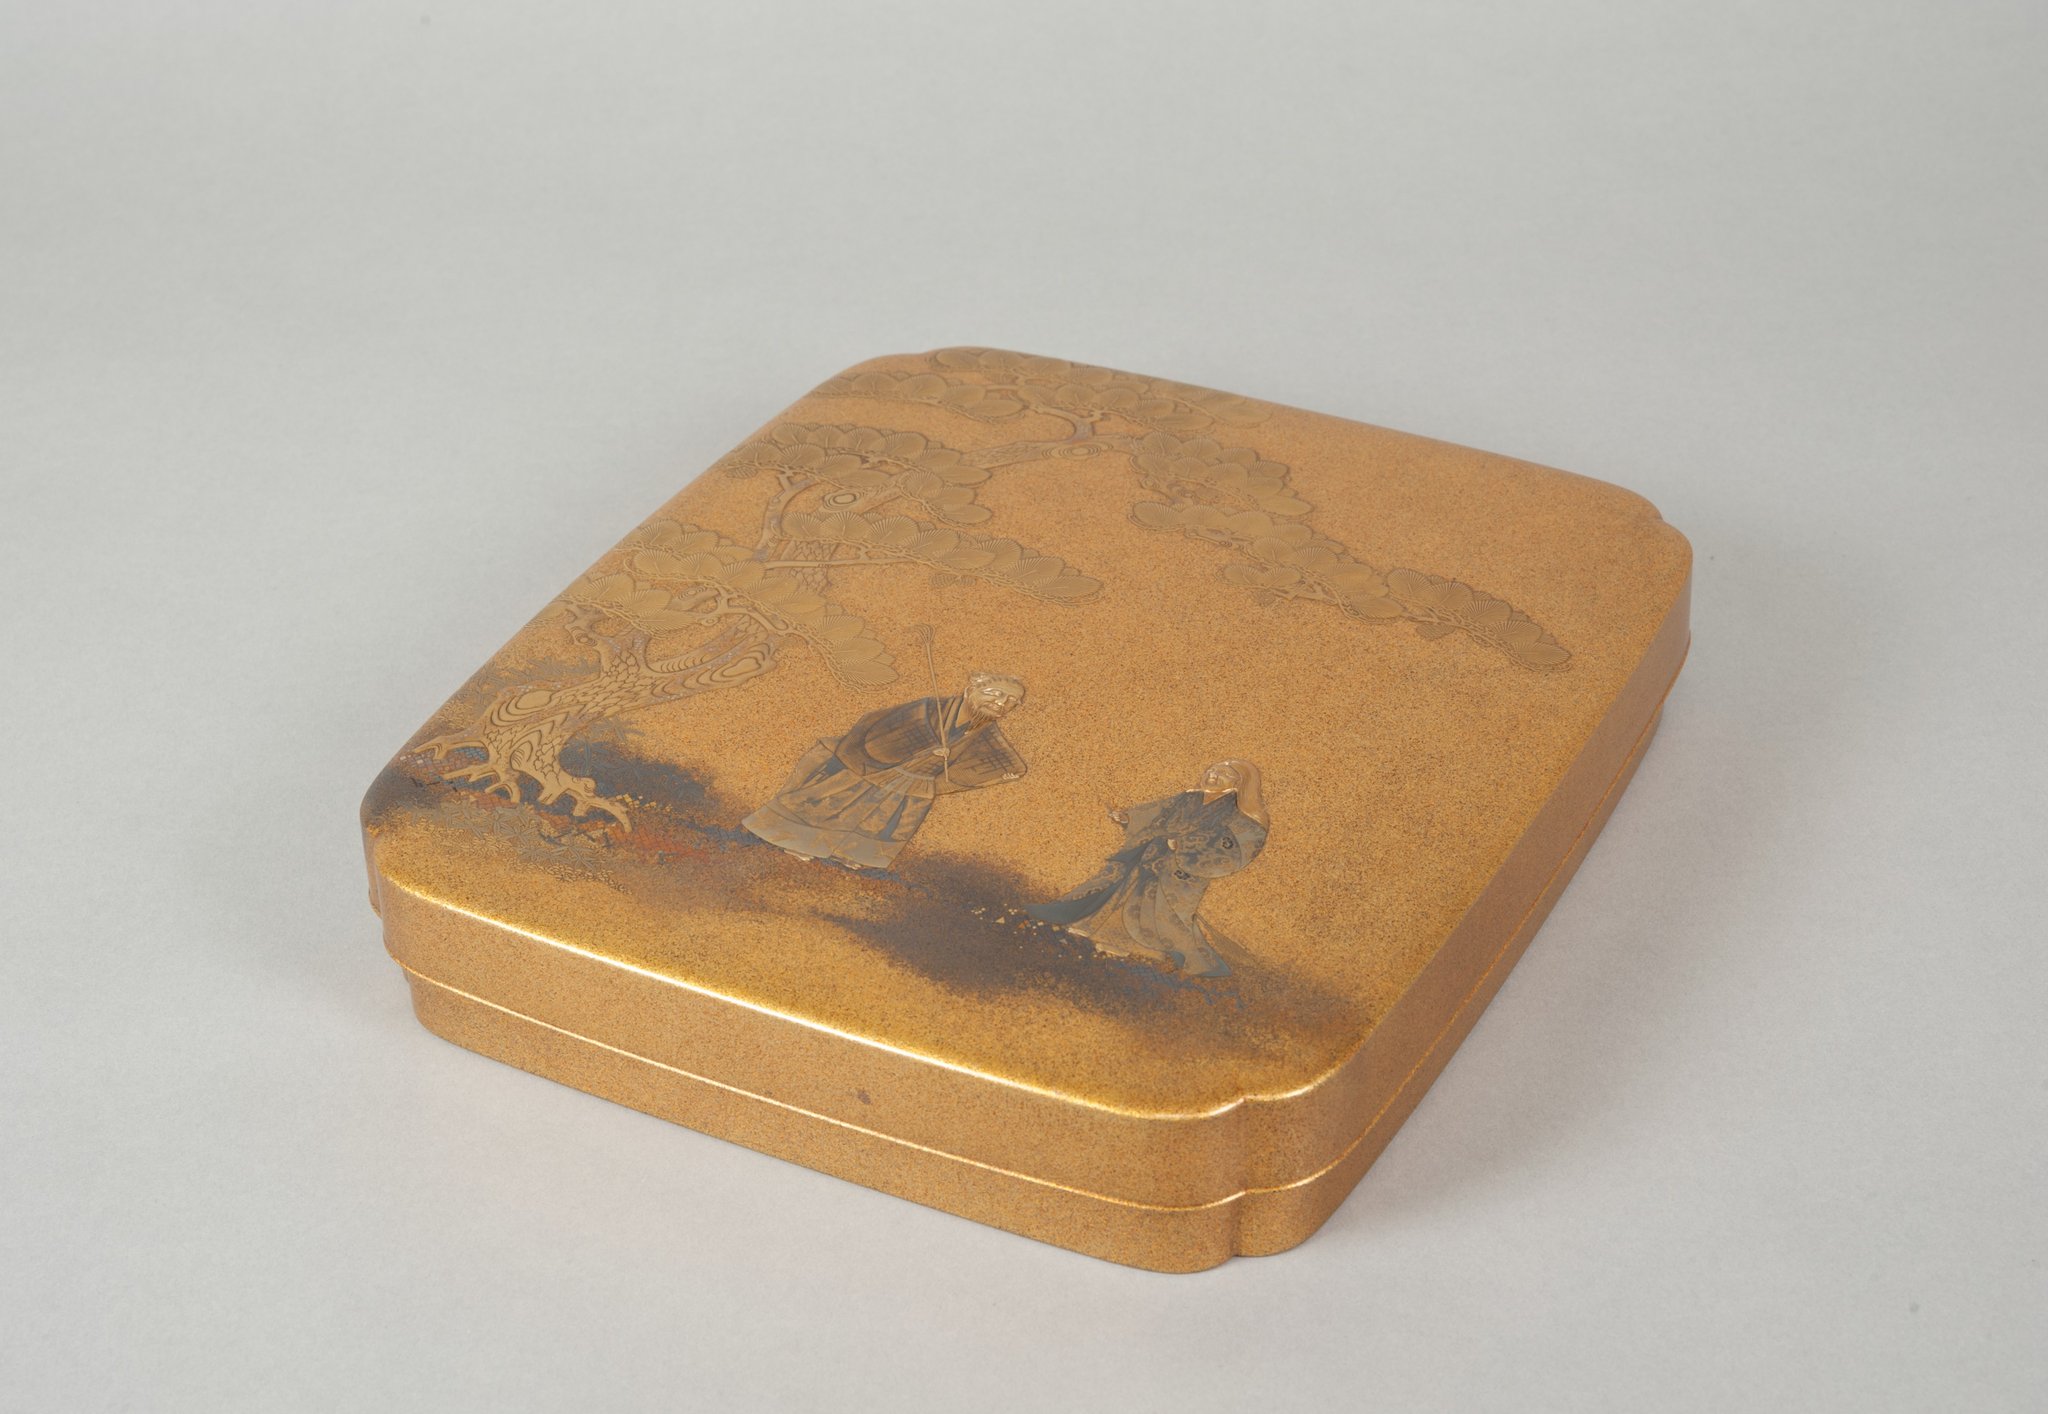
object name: writing box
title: Writing Box with Design of Elderly Couple under Pine from the Noh Play Takasago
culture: japanese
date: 1801-1900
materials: gold, lacquer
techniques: maki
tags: couples,plants